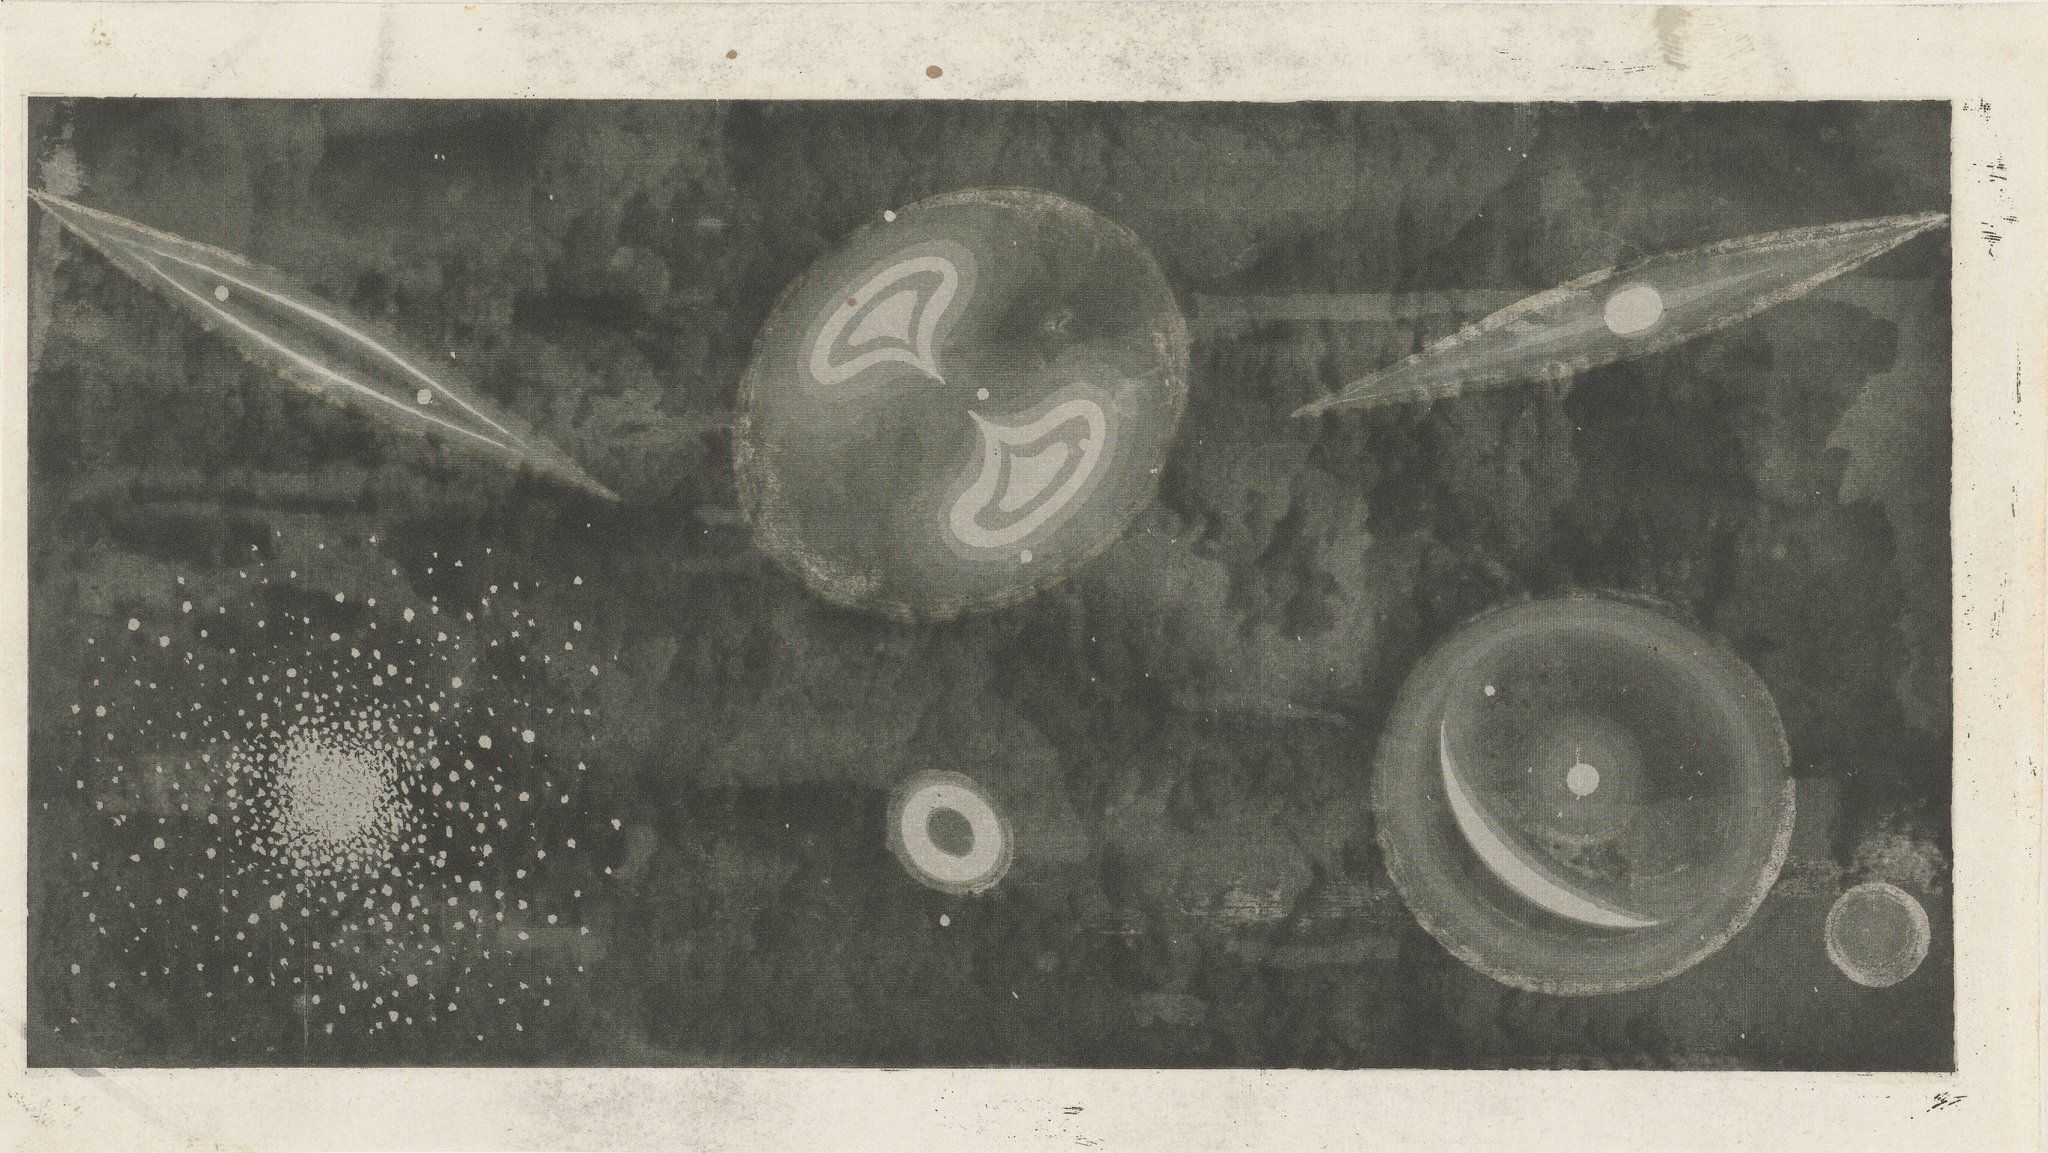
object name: print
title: Hemellichamen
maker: henricus wilhelmus couwenberg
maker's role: draughtsman, print maker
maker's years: 1814-1845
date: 1830-1845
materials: paper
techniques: intaglio, engraving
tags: astronomical phenomena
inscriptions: collector's mark: Lugt 2228